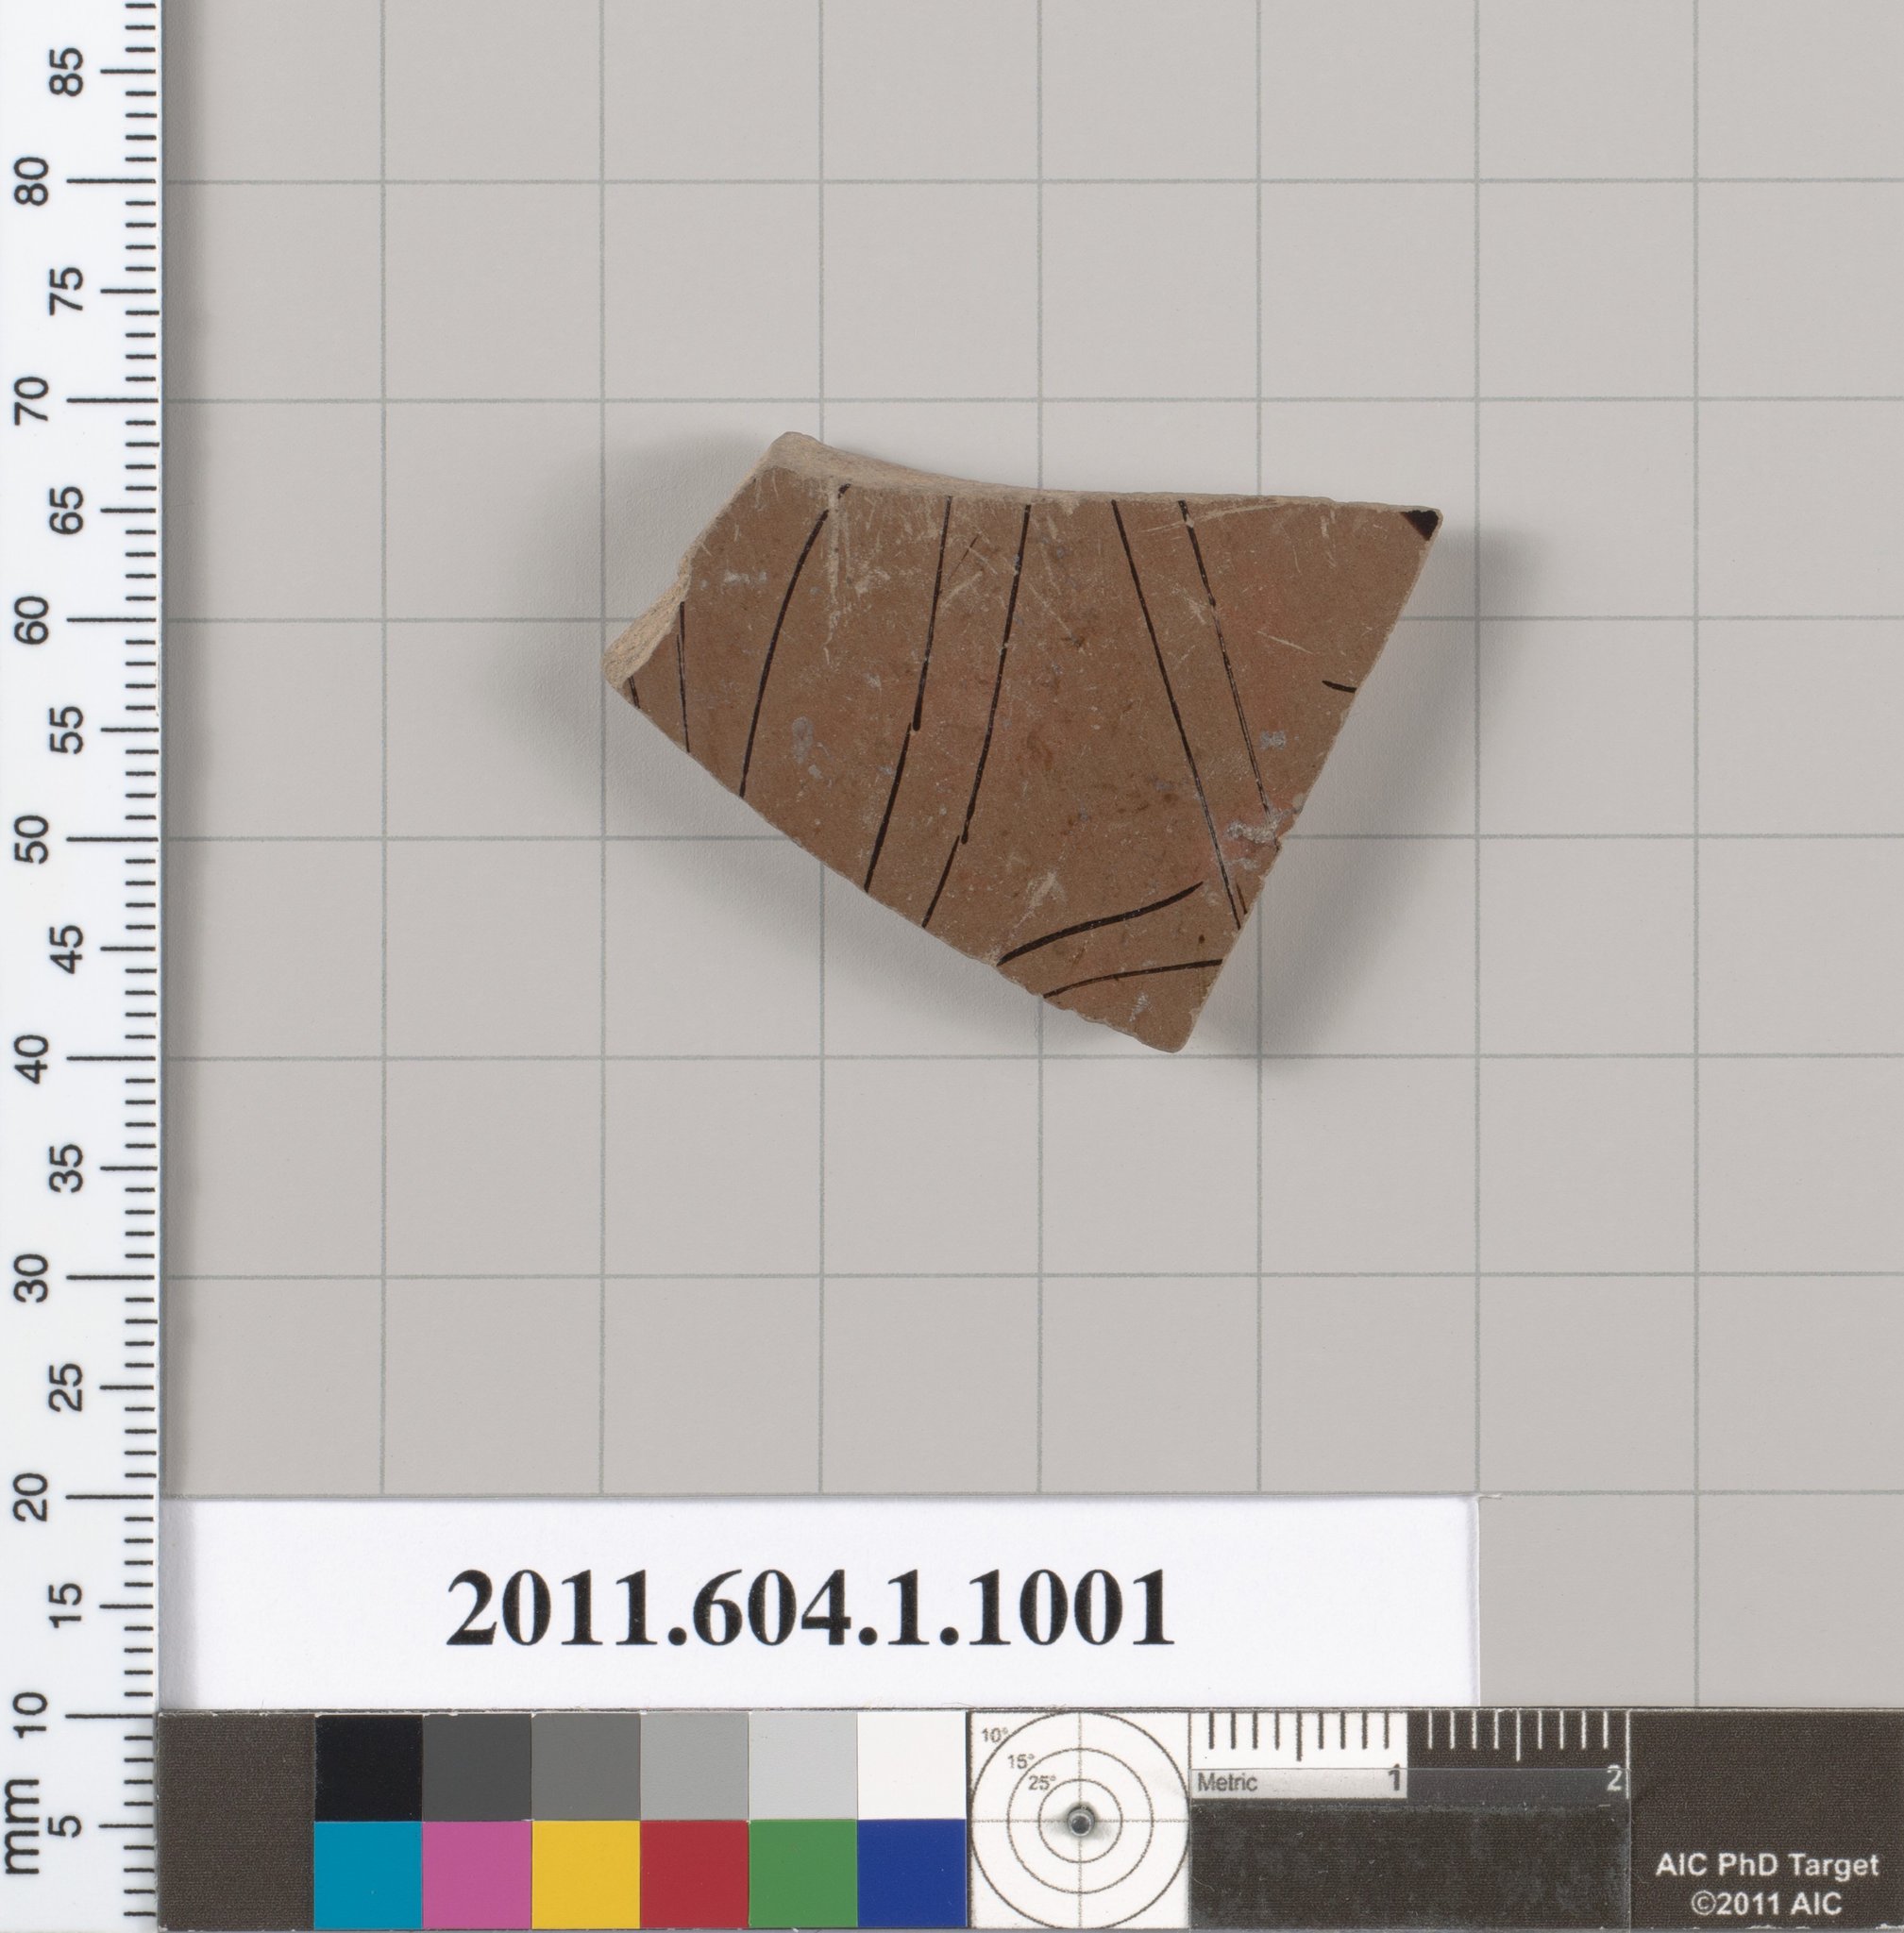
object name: kylix fragment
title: Terracotta fragment of a kylix (drinking cup)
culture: greek, attic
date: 475-451 BCE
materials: terracotta